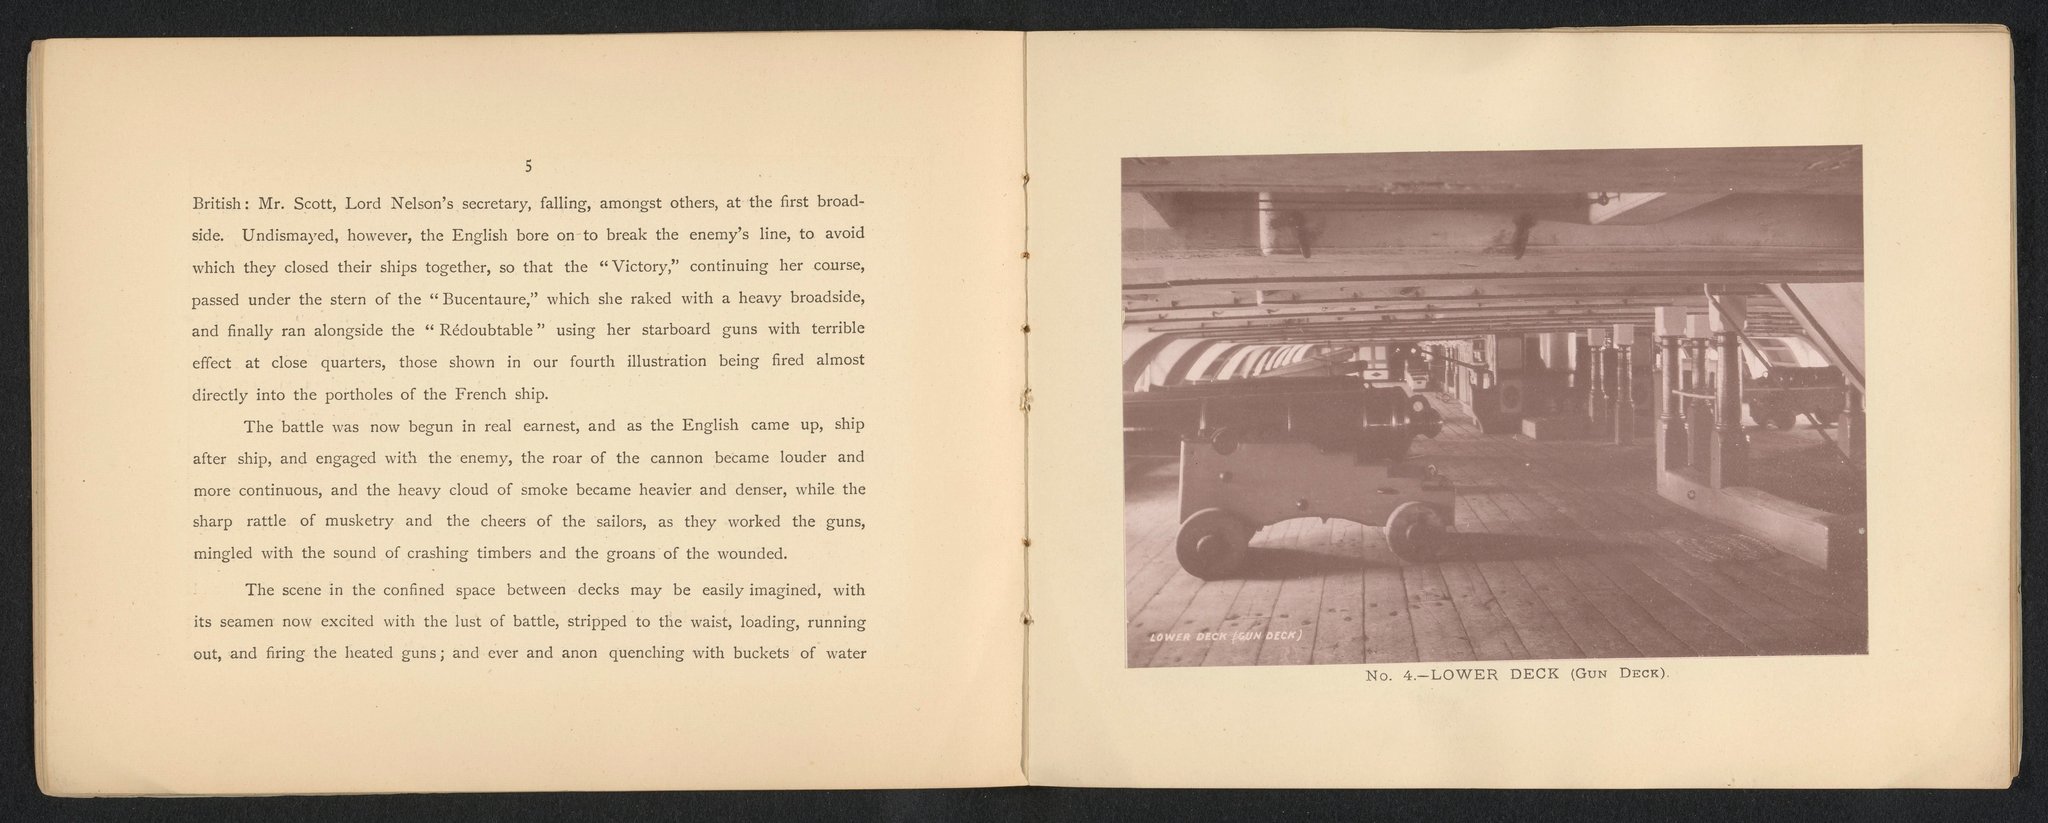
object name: page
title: Lower deck (gun deck)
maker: Anonymous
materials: paper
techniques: photograph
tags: firearms: cannon, parts of ship's interior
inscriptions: number: ‘No. 4.’